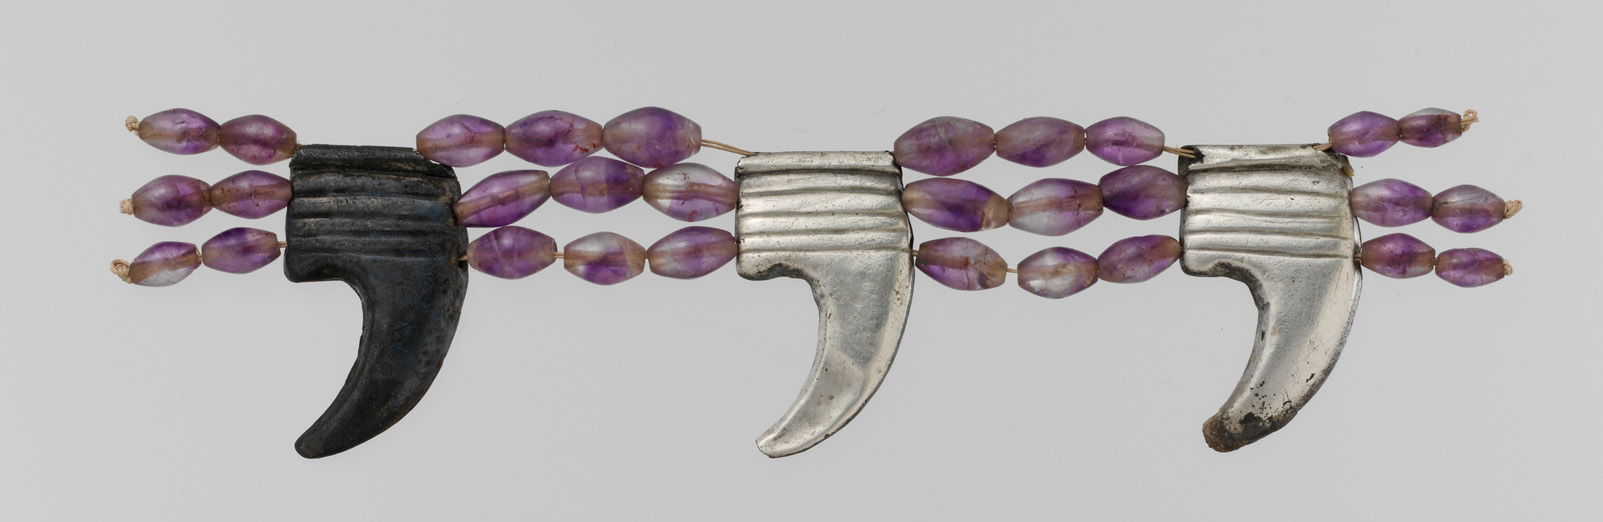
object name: anklet, claw pendant, barrel bead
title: Anklet, Reconstructed Using Claw Pendants and Barrel Beads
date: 1850-1775 BCE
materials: gemstone, silver, wood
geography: egypt